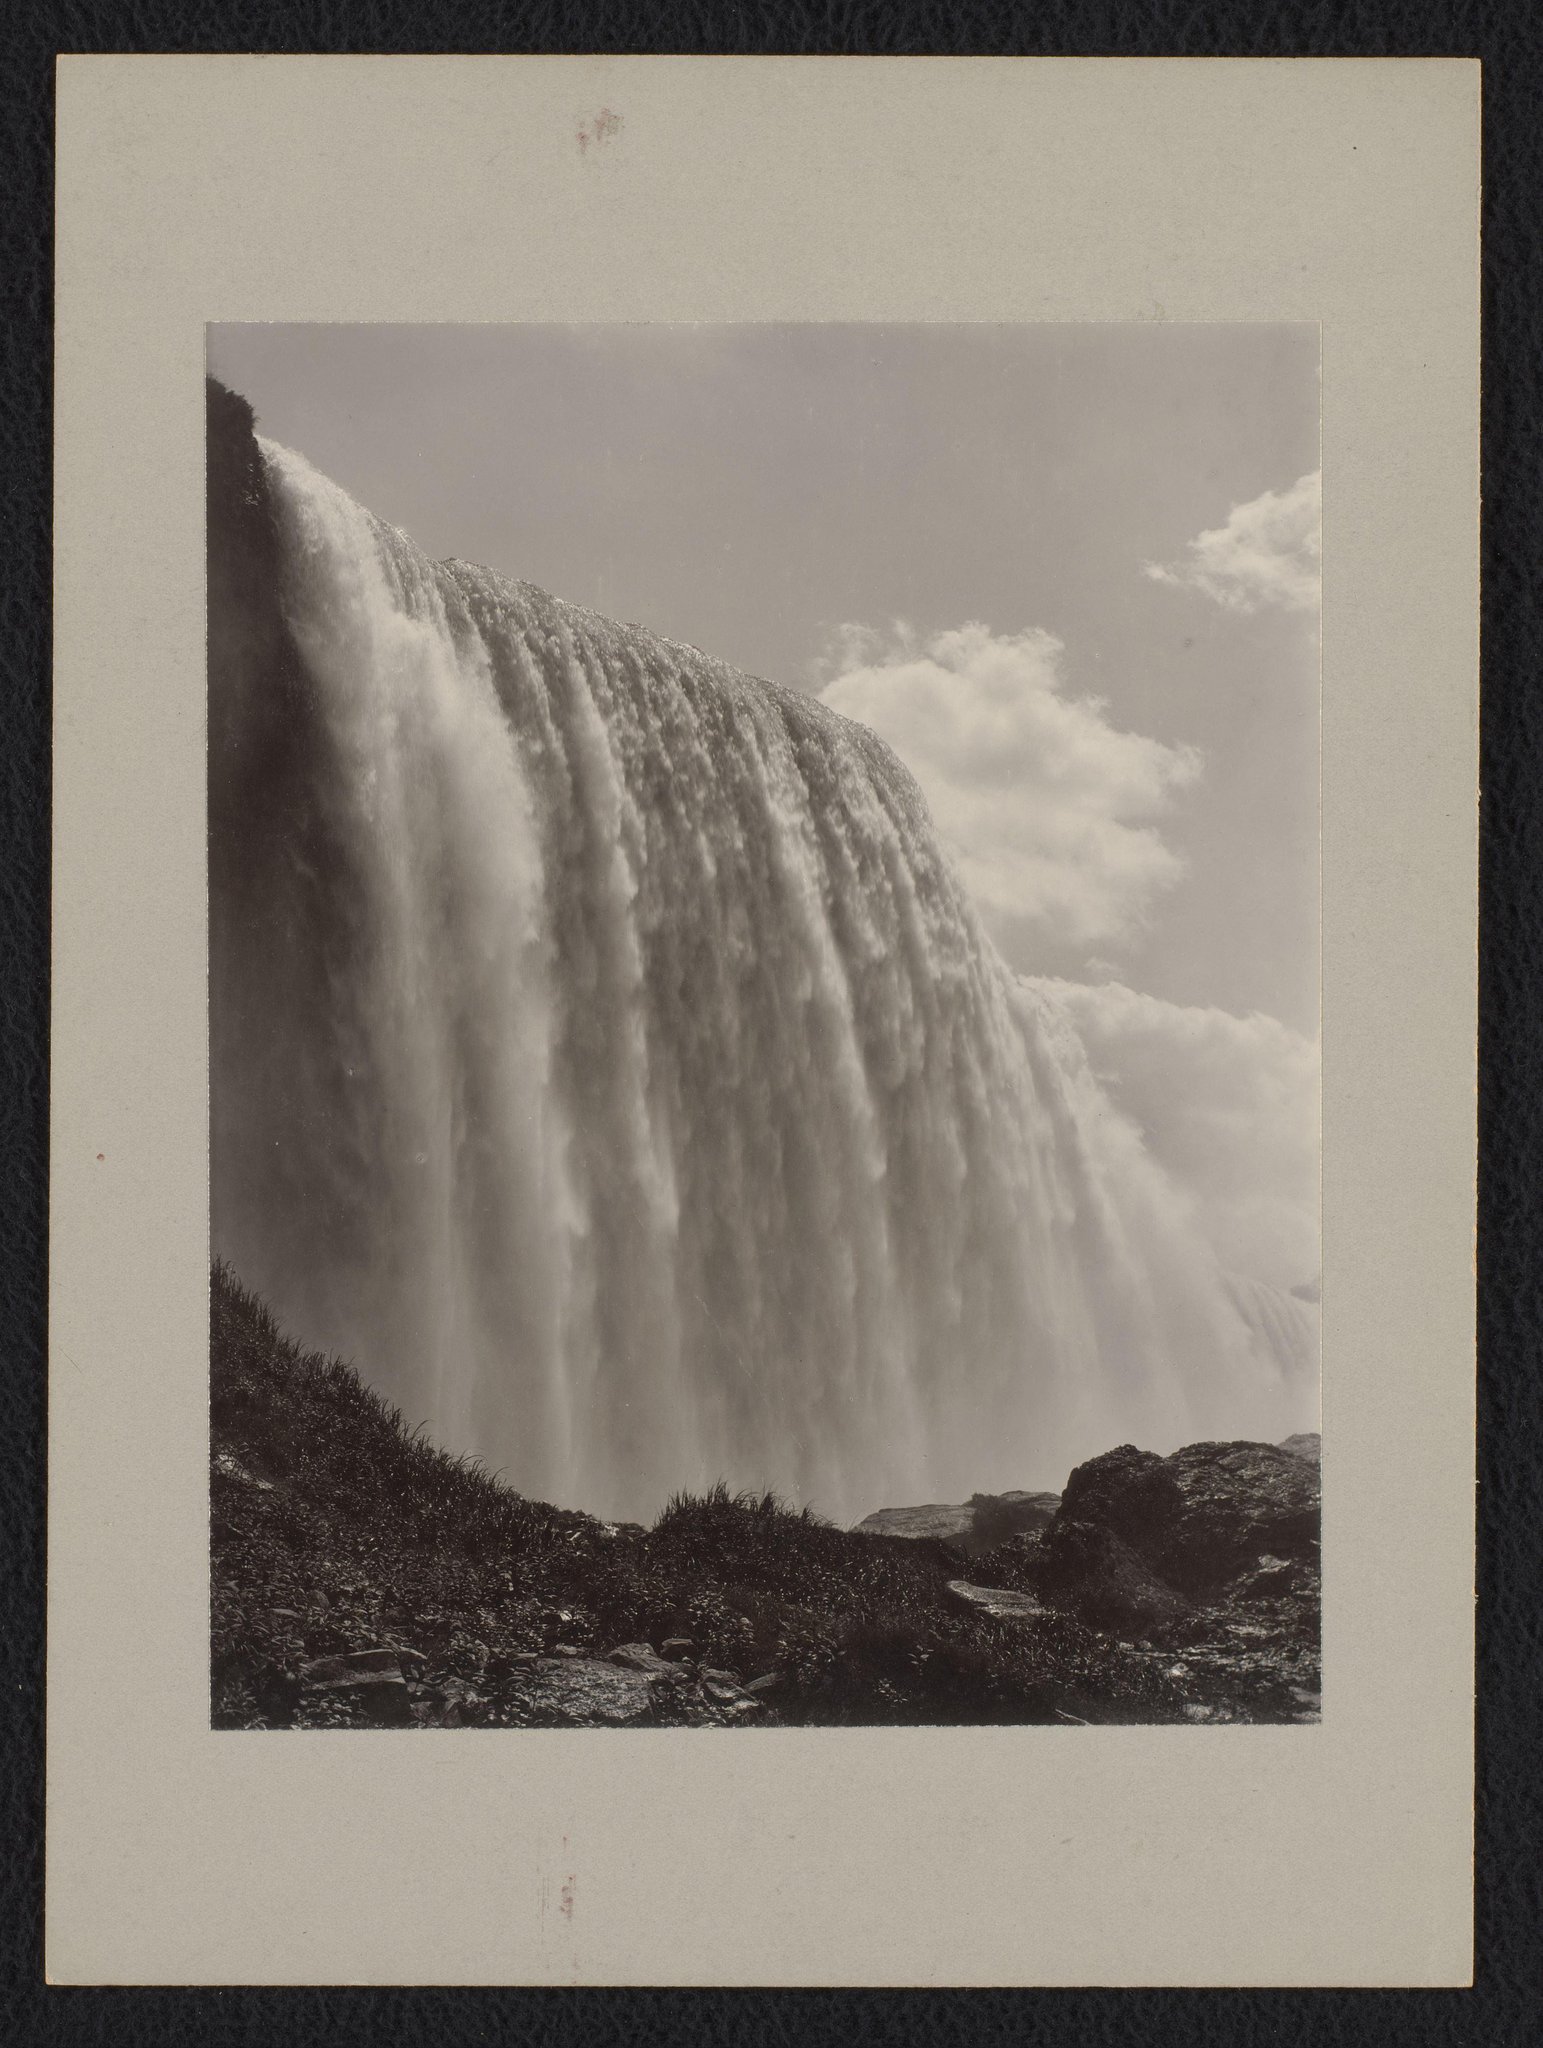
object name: photograph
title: Niagara waterval van onderen gezien, Verenigde Staten/Canada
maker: Anonymous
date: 1895-1915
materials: cardboard, photographic support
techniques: gelatin silver print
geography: niagara falls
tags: niagara falls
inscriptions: number: ‘9.’